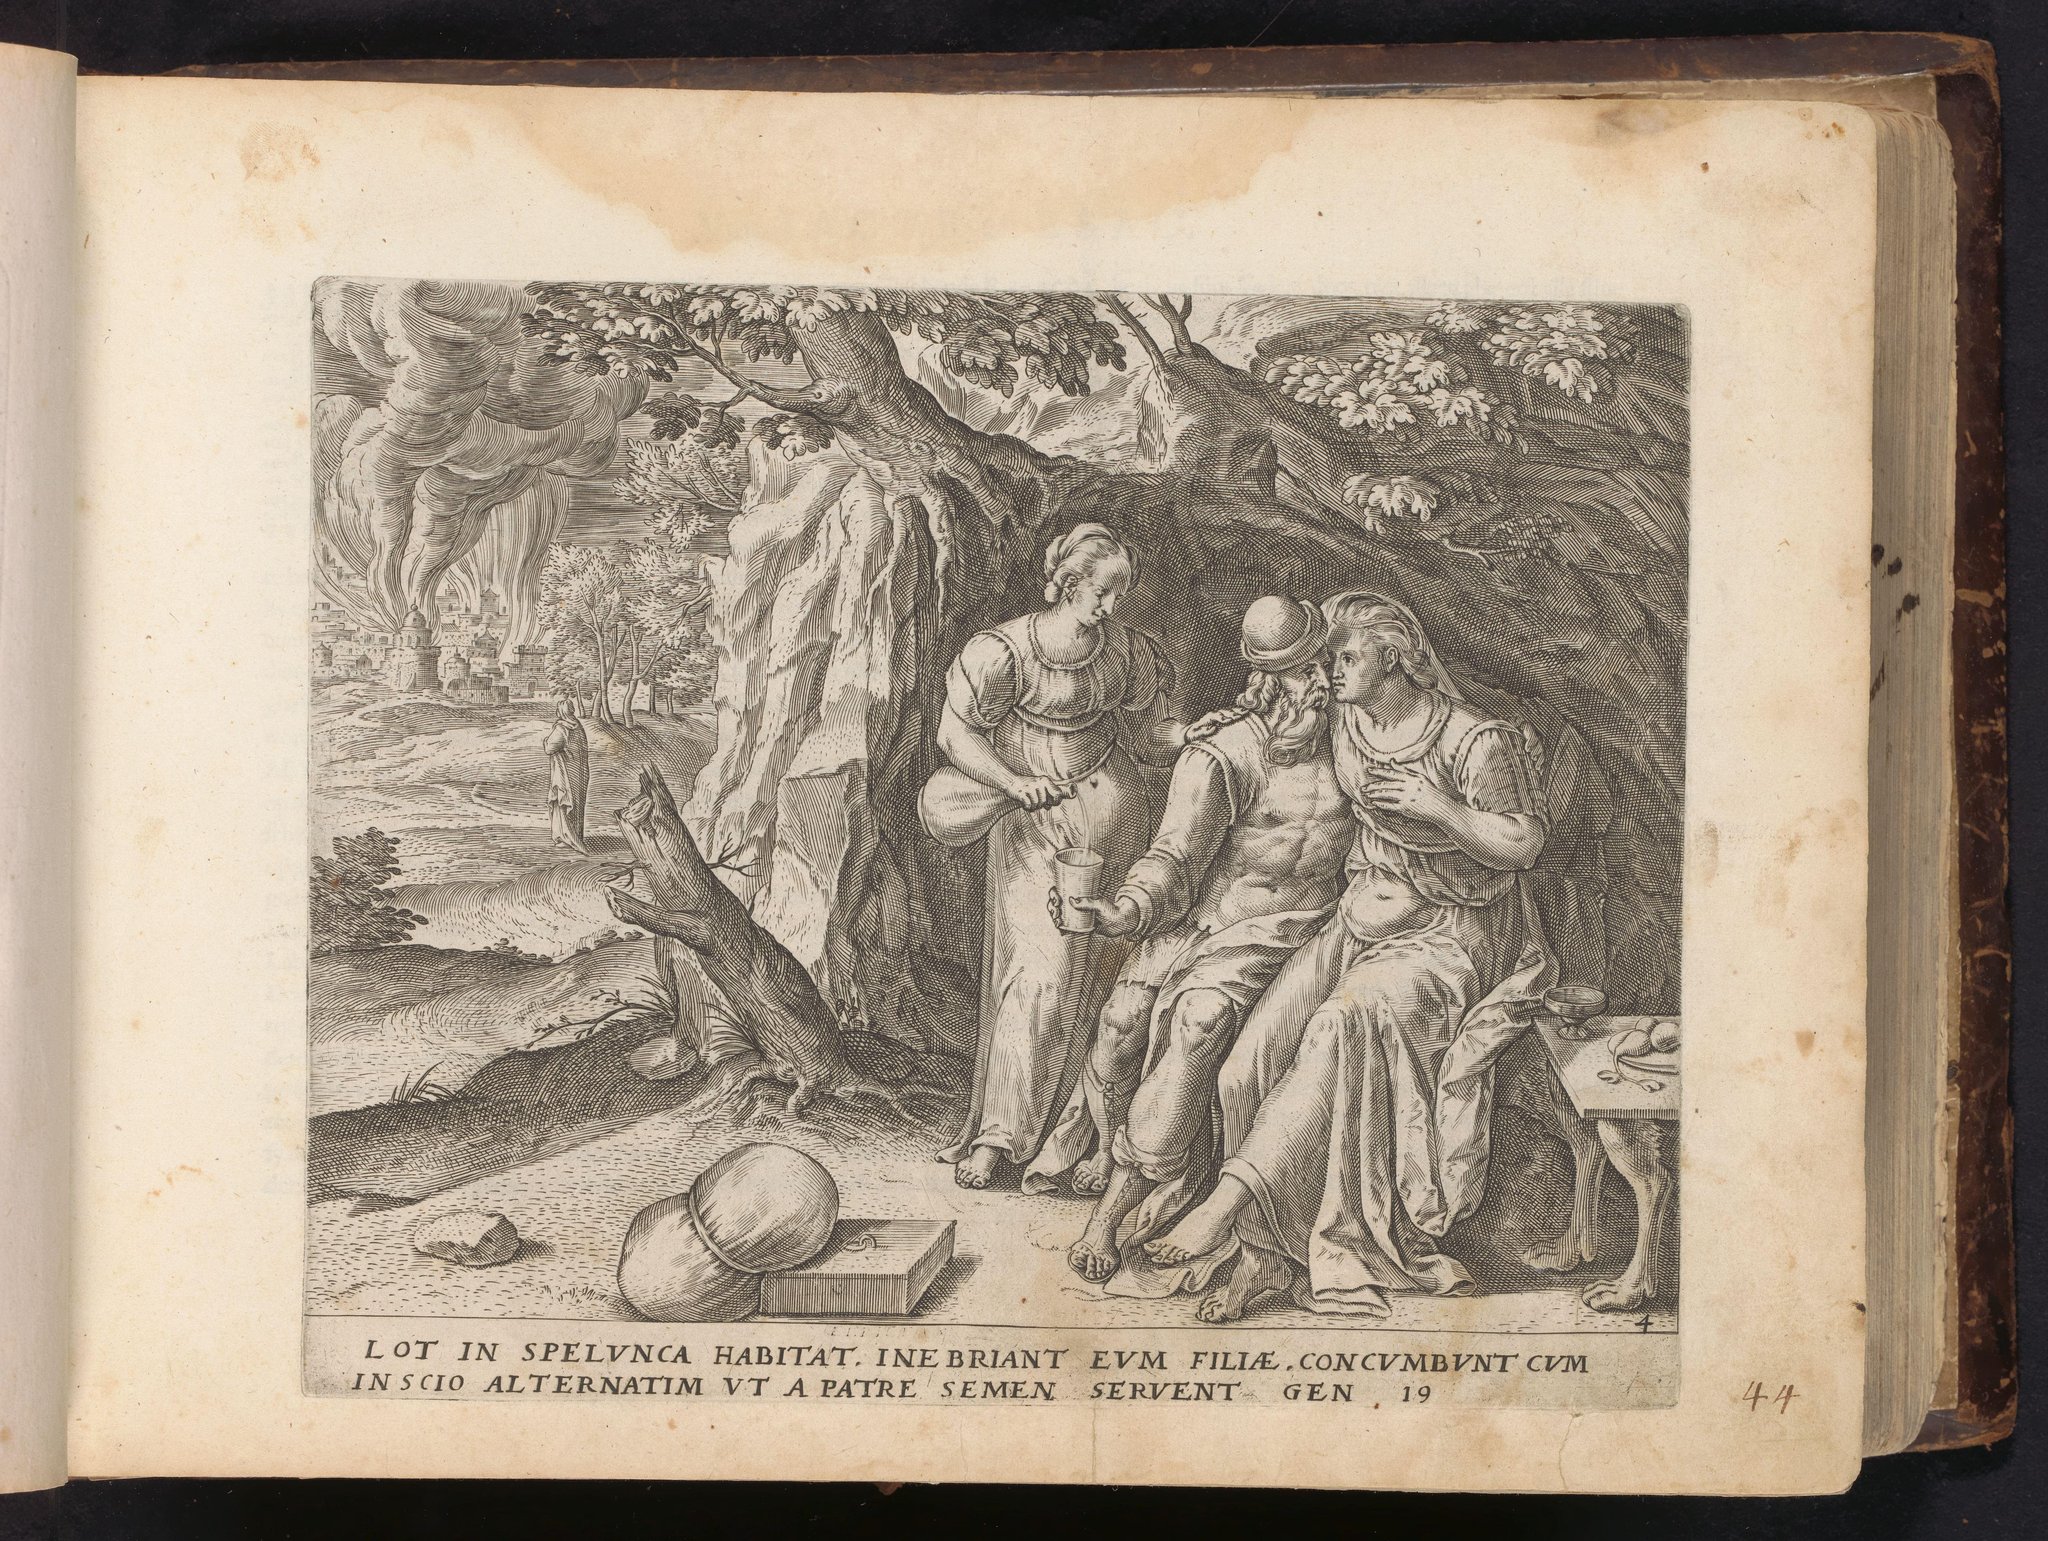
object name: album leaf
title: Van Loth en Sodoma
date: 1579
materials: paper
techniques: engraving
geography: alkmaar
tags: lot's daughters make their father drunk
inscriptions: number: ‘44’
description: Lot zit in een grot naast een van zijn dochters. Zijn andere dochter schenkt zijn beker vol wijn. Op de achtergrond de brand van de steden Sodom en Gomorra en de vrouw van Lot als zoutpilaar. Onder de voorstelling een verwijzing in het Latijn naar de Bijbeltekst in Gen. 19. Deze prent maakt deel uit van een album.